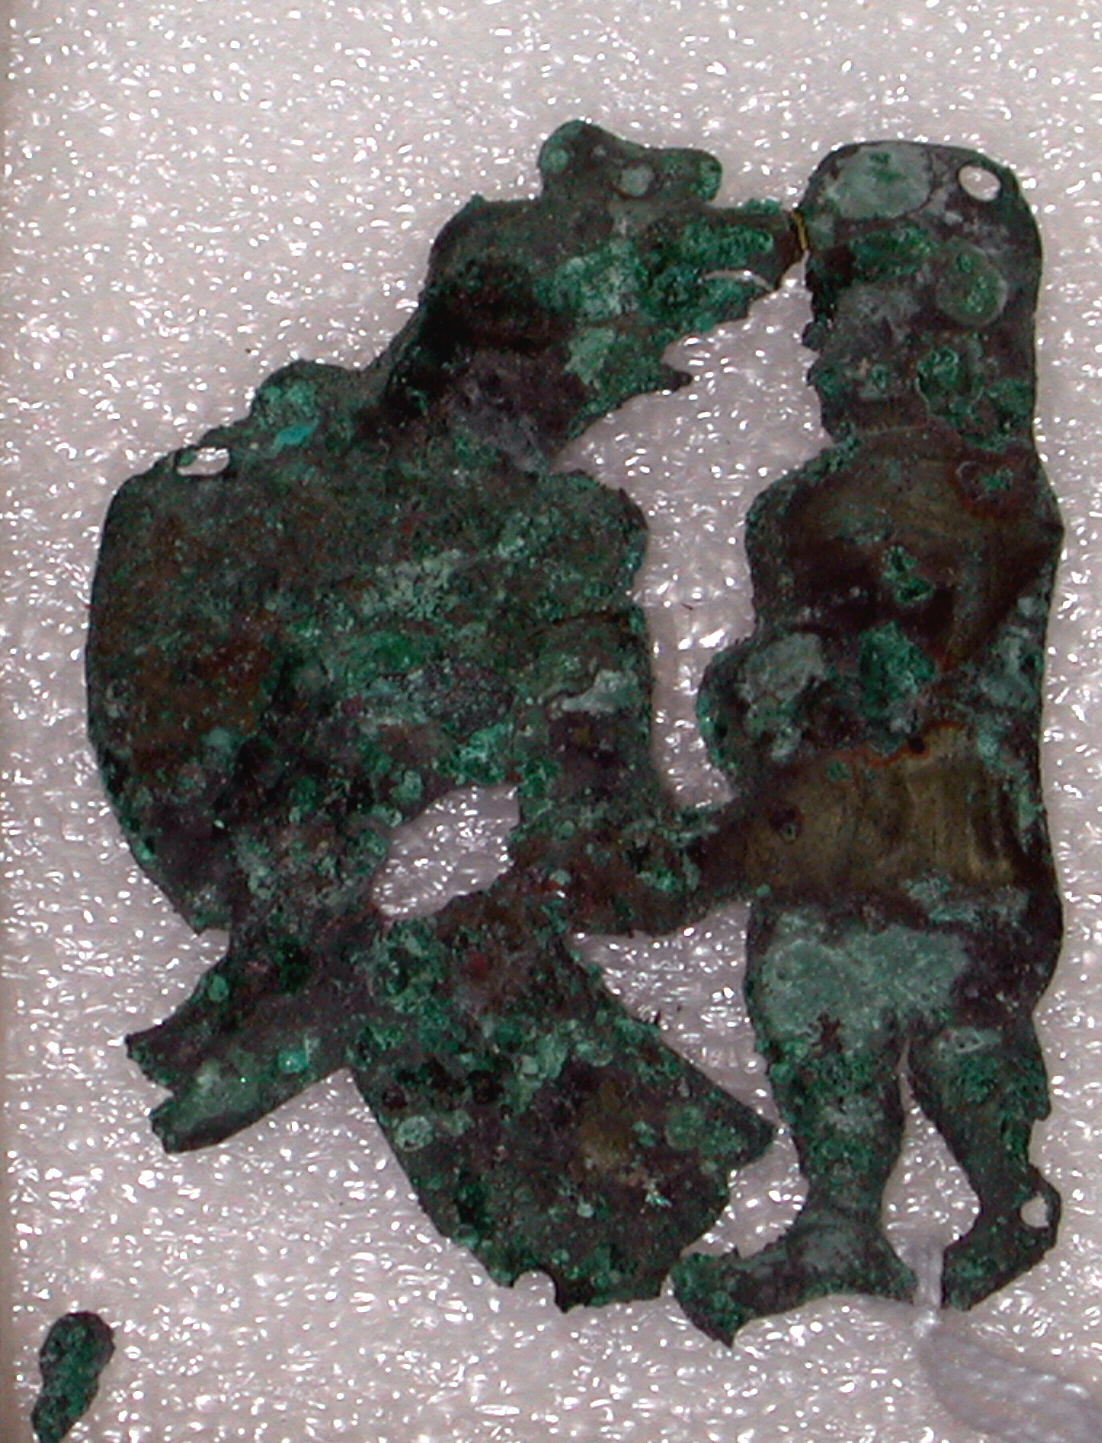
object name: ornament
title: Animal Ornament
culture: moche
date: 501-700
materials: metal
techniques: gilding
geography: peru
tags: human figures,animals